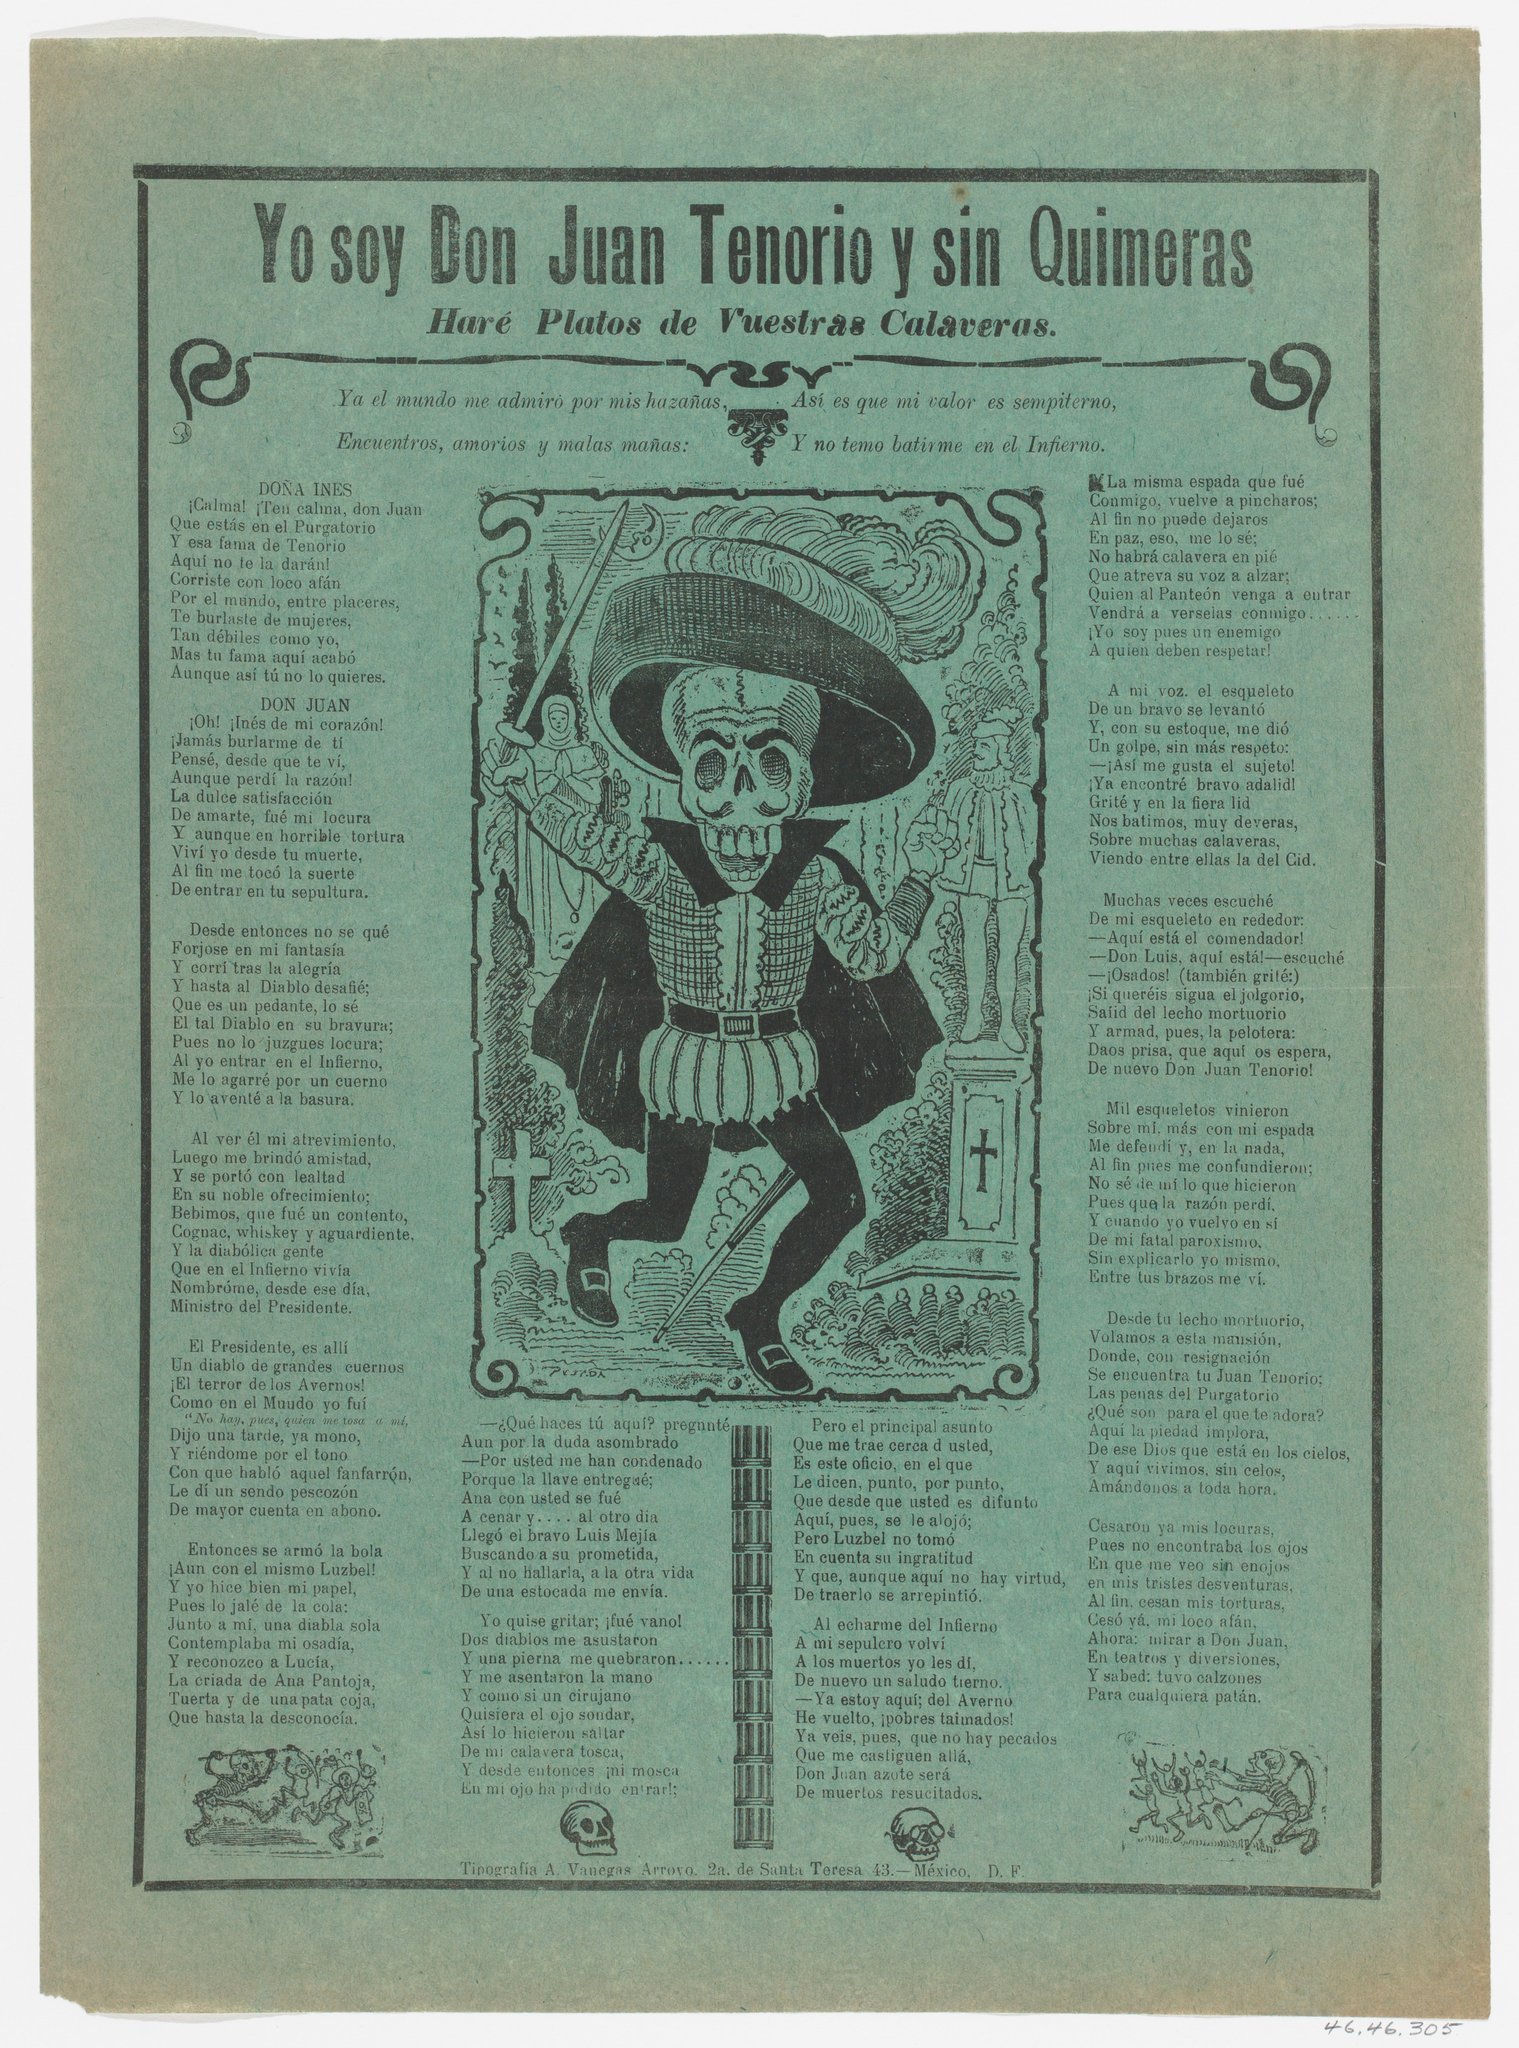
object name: print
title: The skeleton of Don Juan Tenorio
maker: josé guadalupe posada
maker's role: artist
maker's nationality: mexican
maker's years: 1852-1913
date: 1900-1910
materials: paper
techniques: letterpress, lithography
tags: skeletons